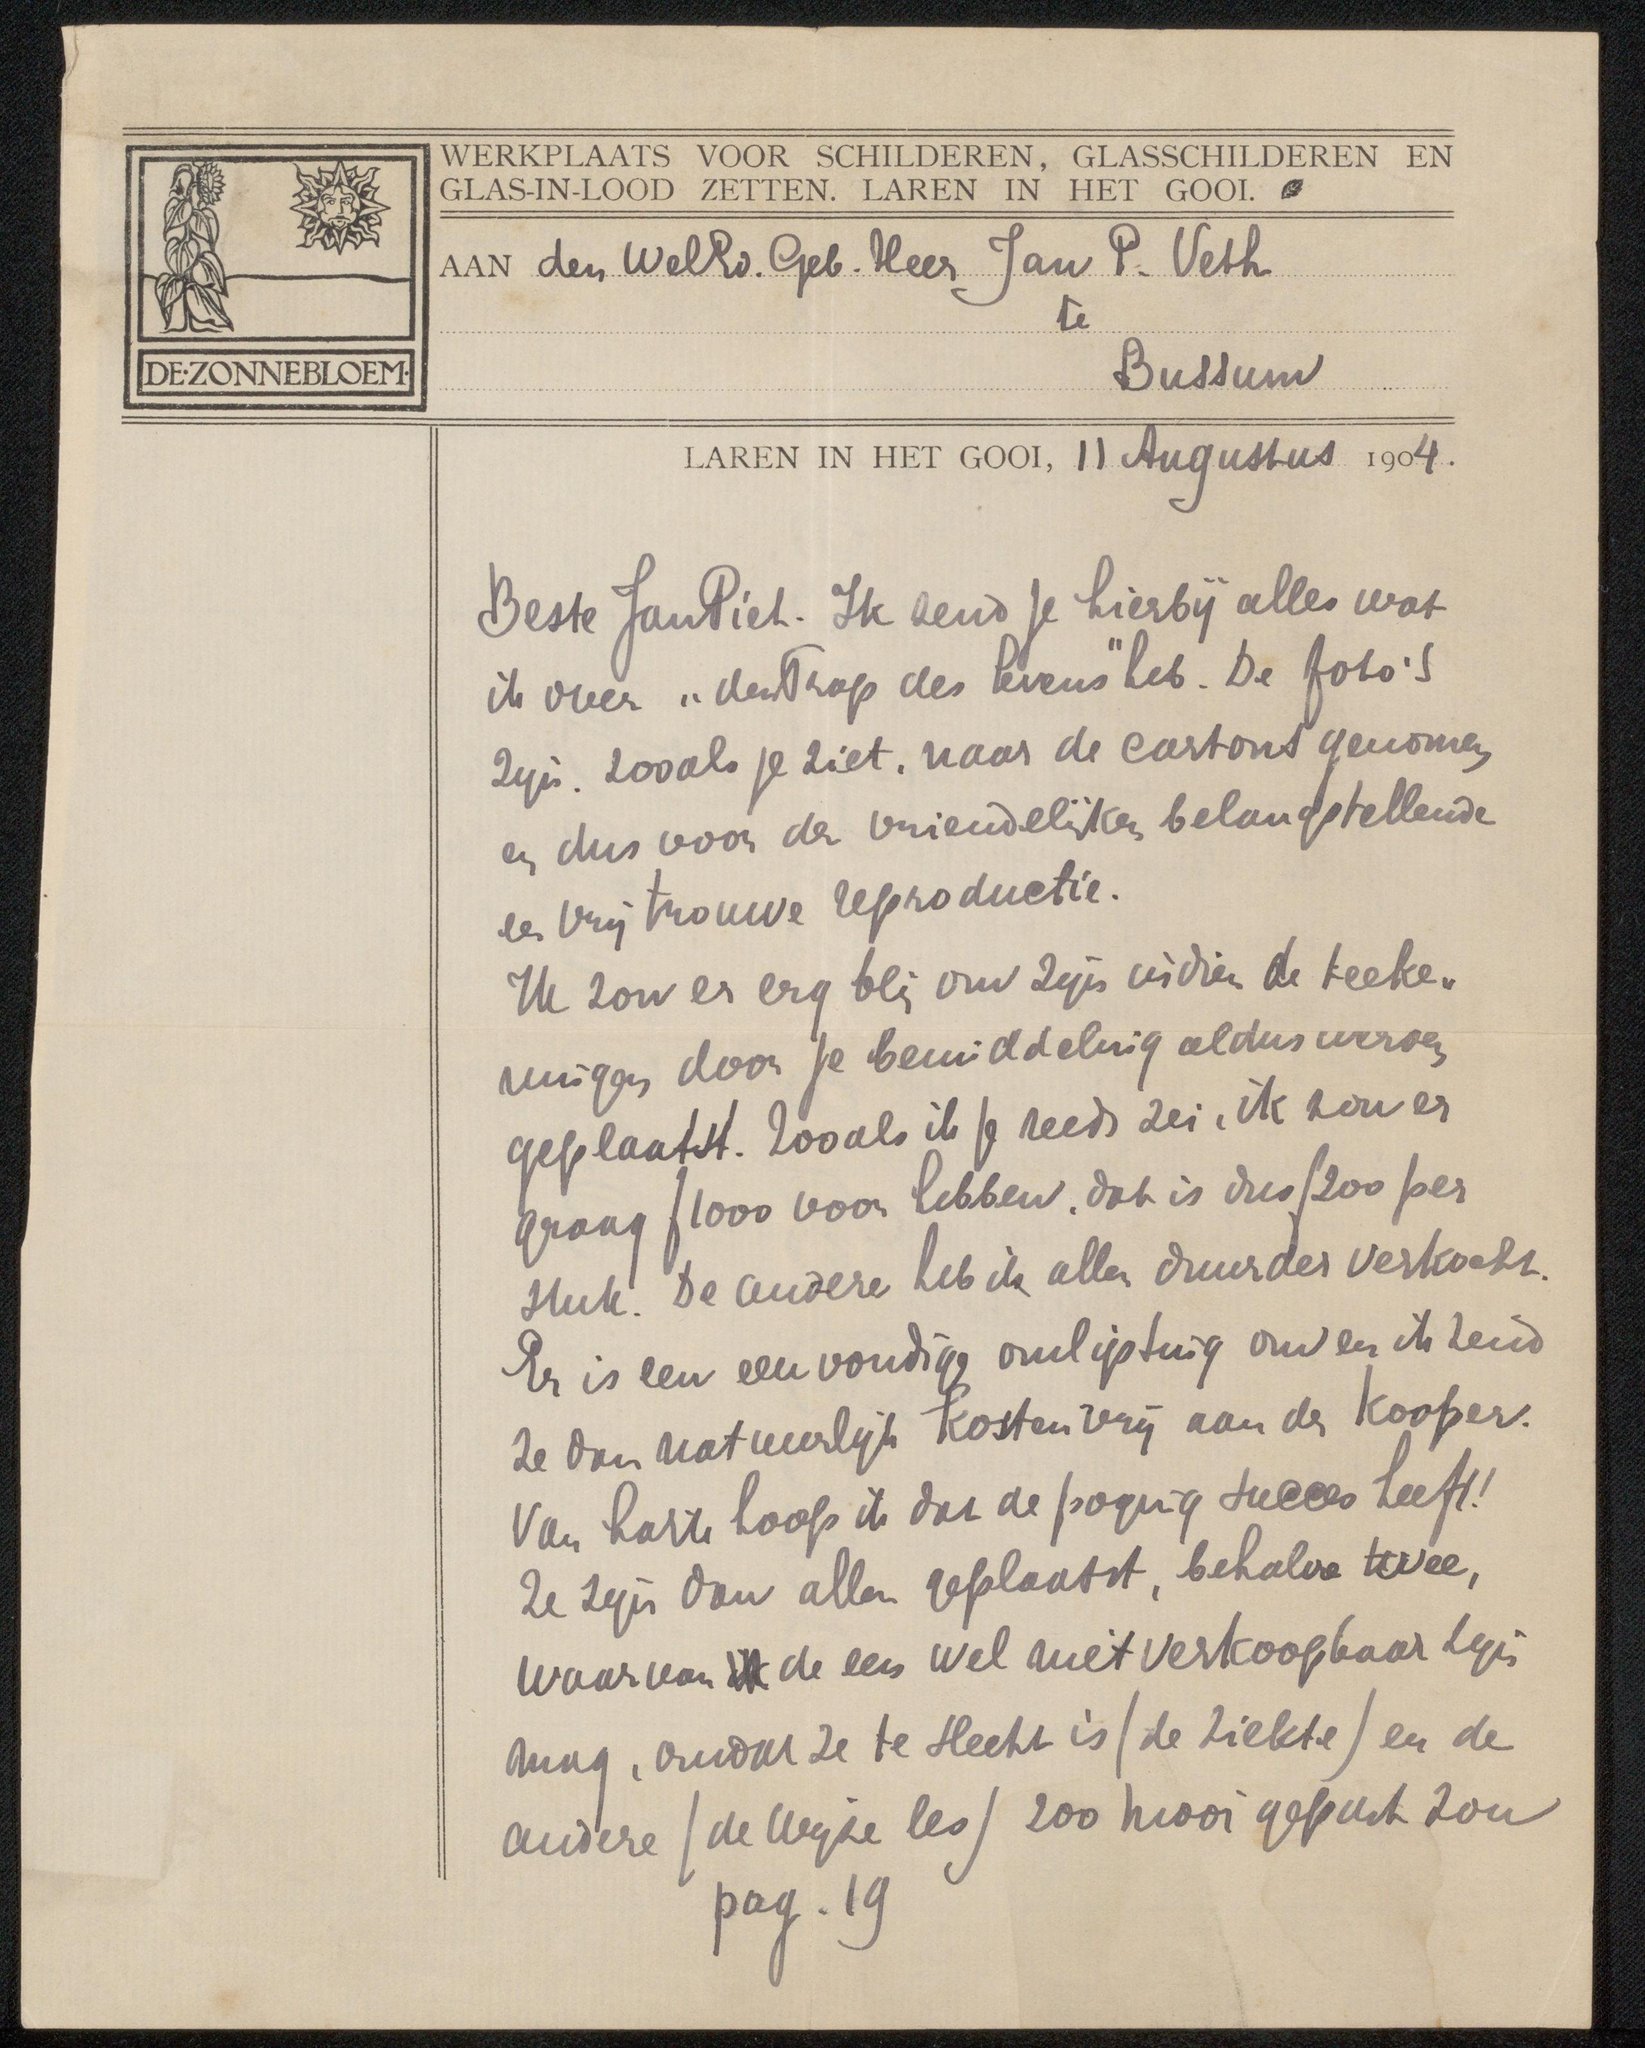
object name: letter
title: Brief aan Jan Veth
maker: antoon derkinderen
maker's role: draughtsman, painter, print maker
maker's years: 1859-1925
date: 1904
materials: ink, paper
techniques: pen, printing, writing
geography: laren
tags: amsterdam, painter, draughtsman, designer, jan veth, arnhem, print maker, louis stracké, art trade, art shop, drawing, photography, cinematography, money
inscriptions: collector's mark: ‘RPK’